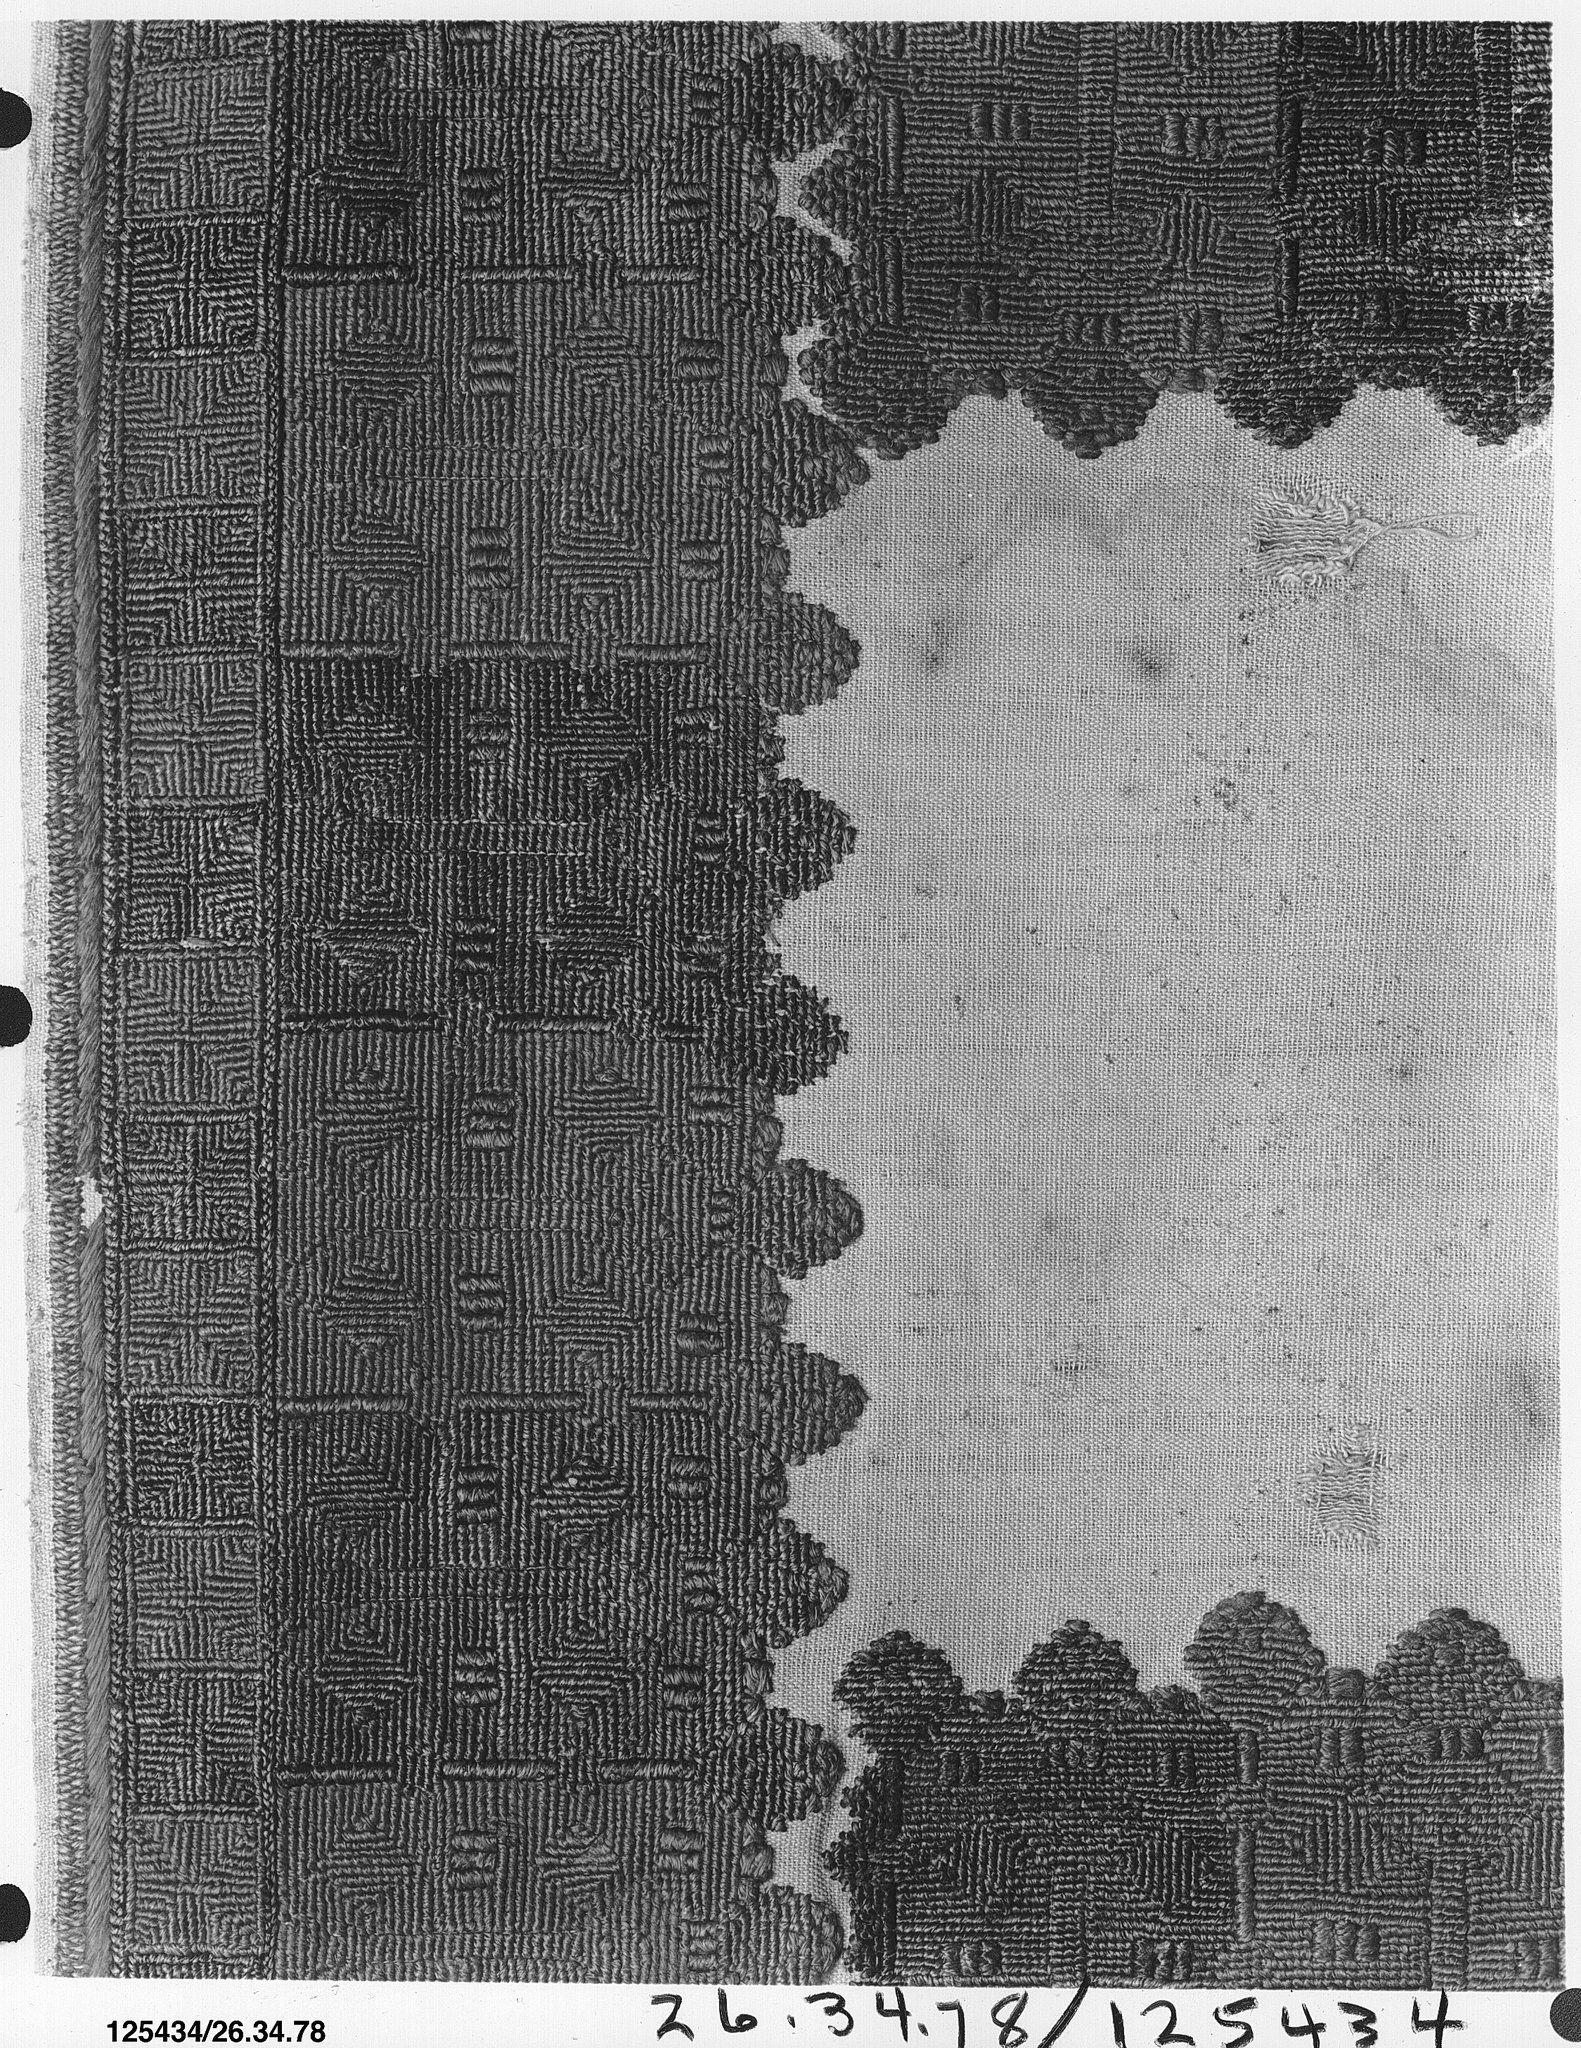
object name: skirt band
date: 1601-1700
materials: cotton, silk